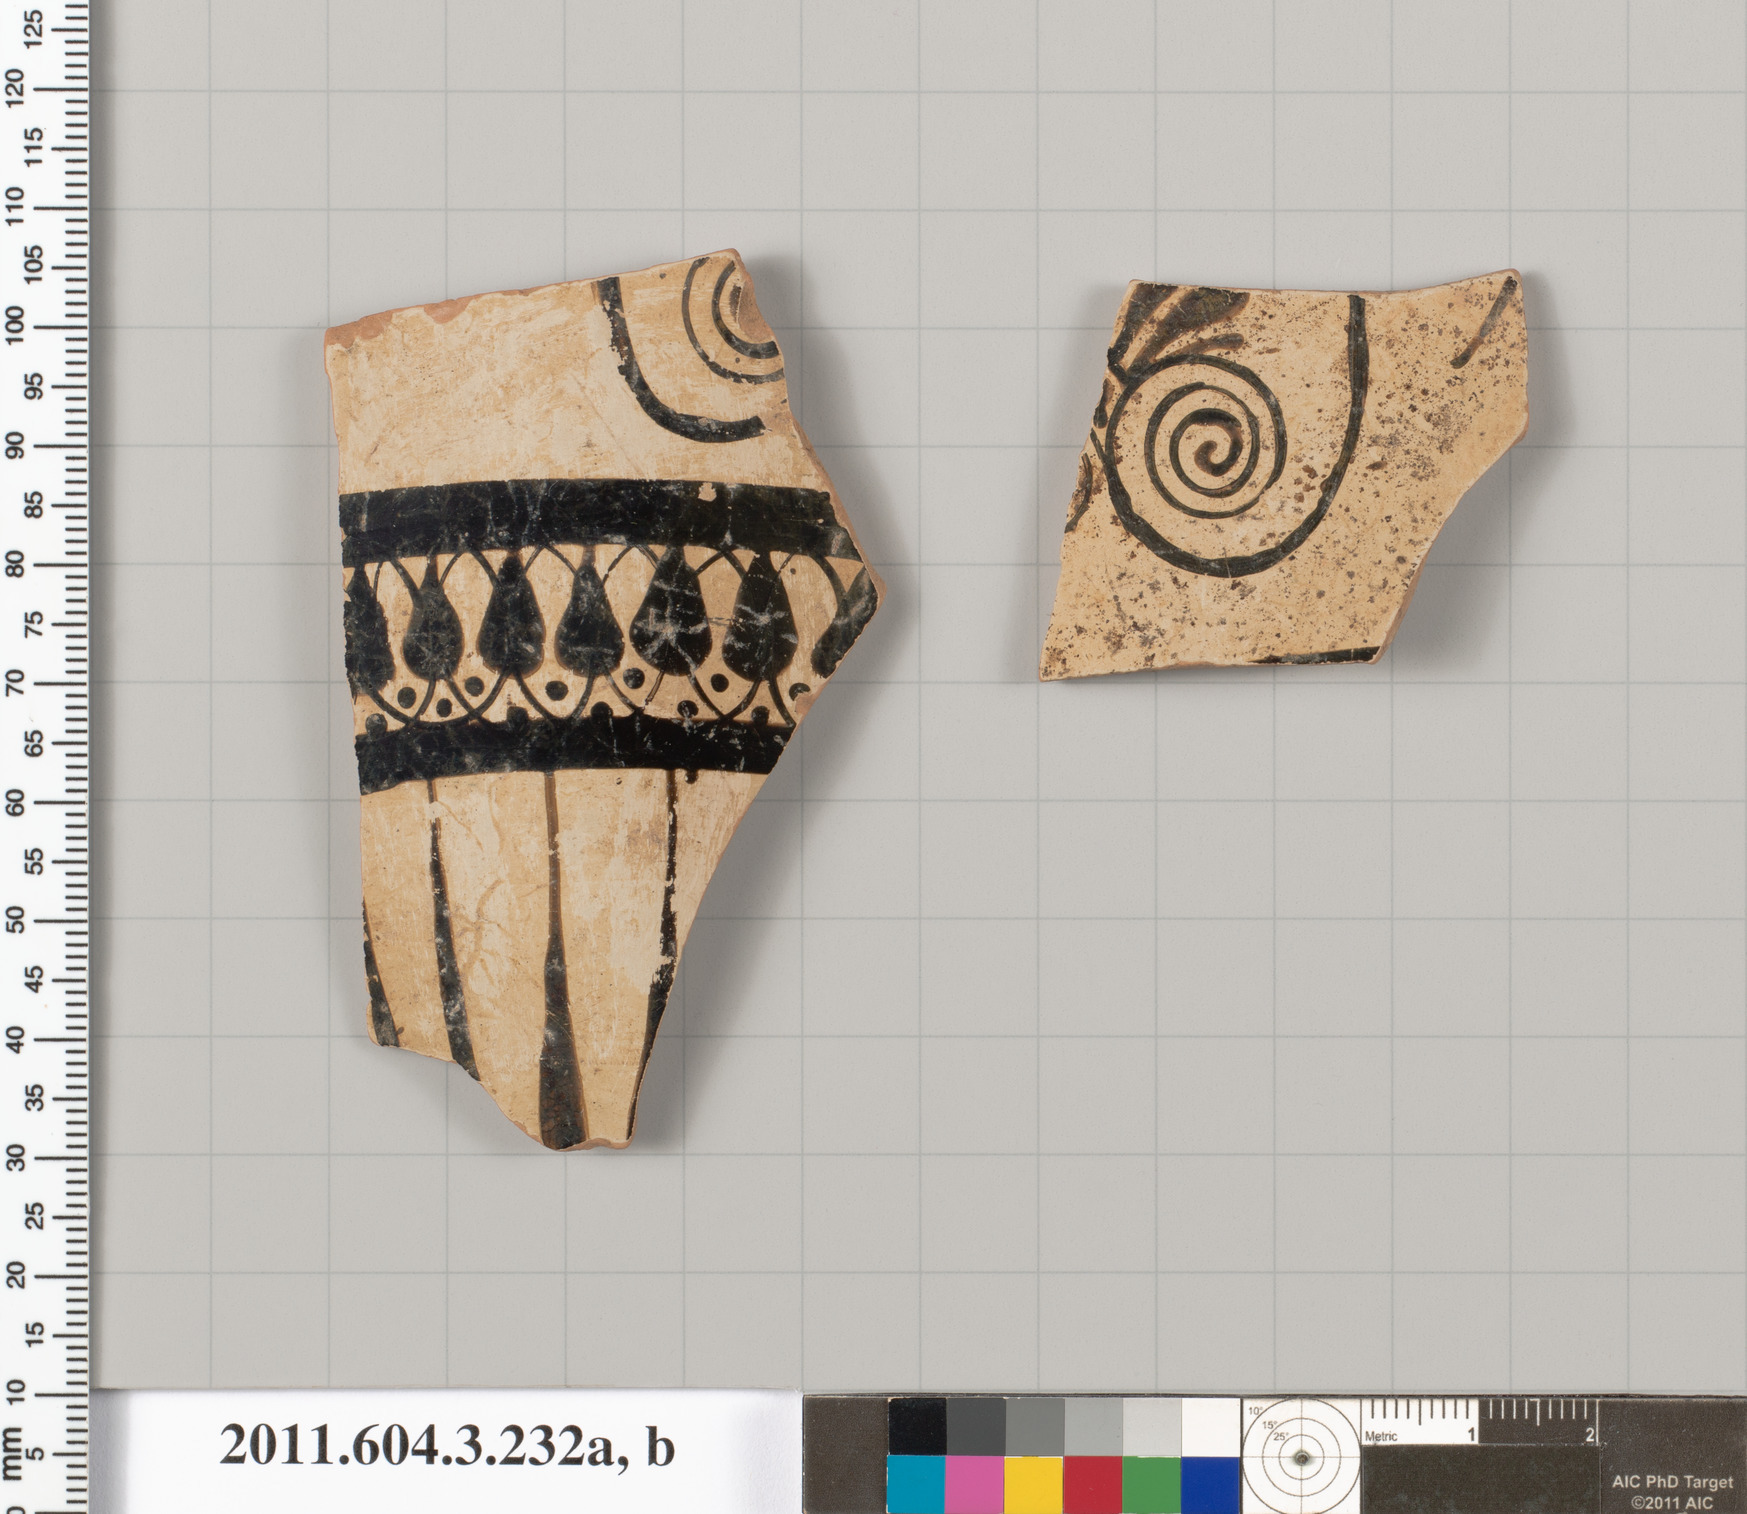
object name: neck amphora fragment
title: Terracotta fragments of a neck-amphora (jar)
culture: greek, attic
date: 534-468 BCE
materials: terracotta